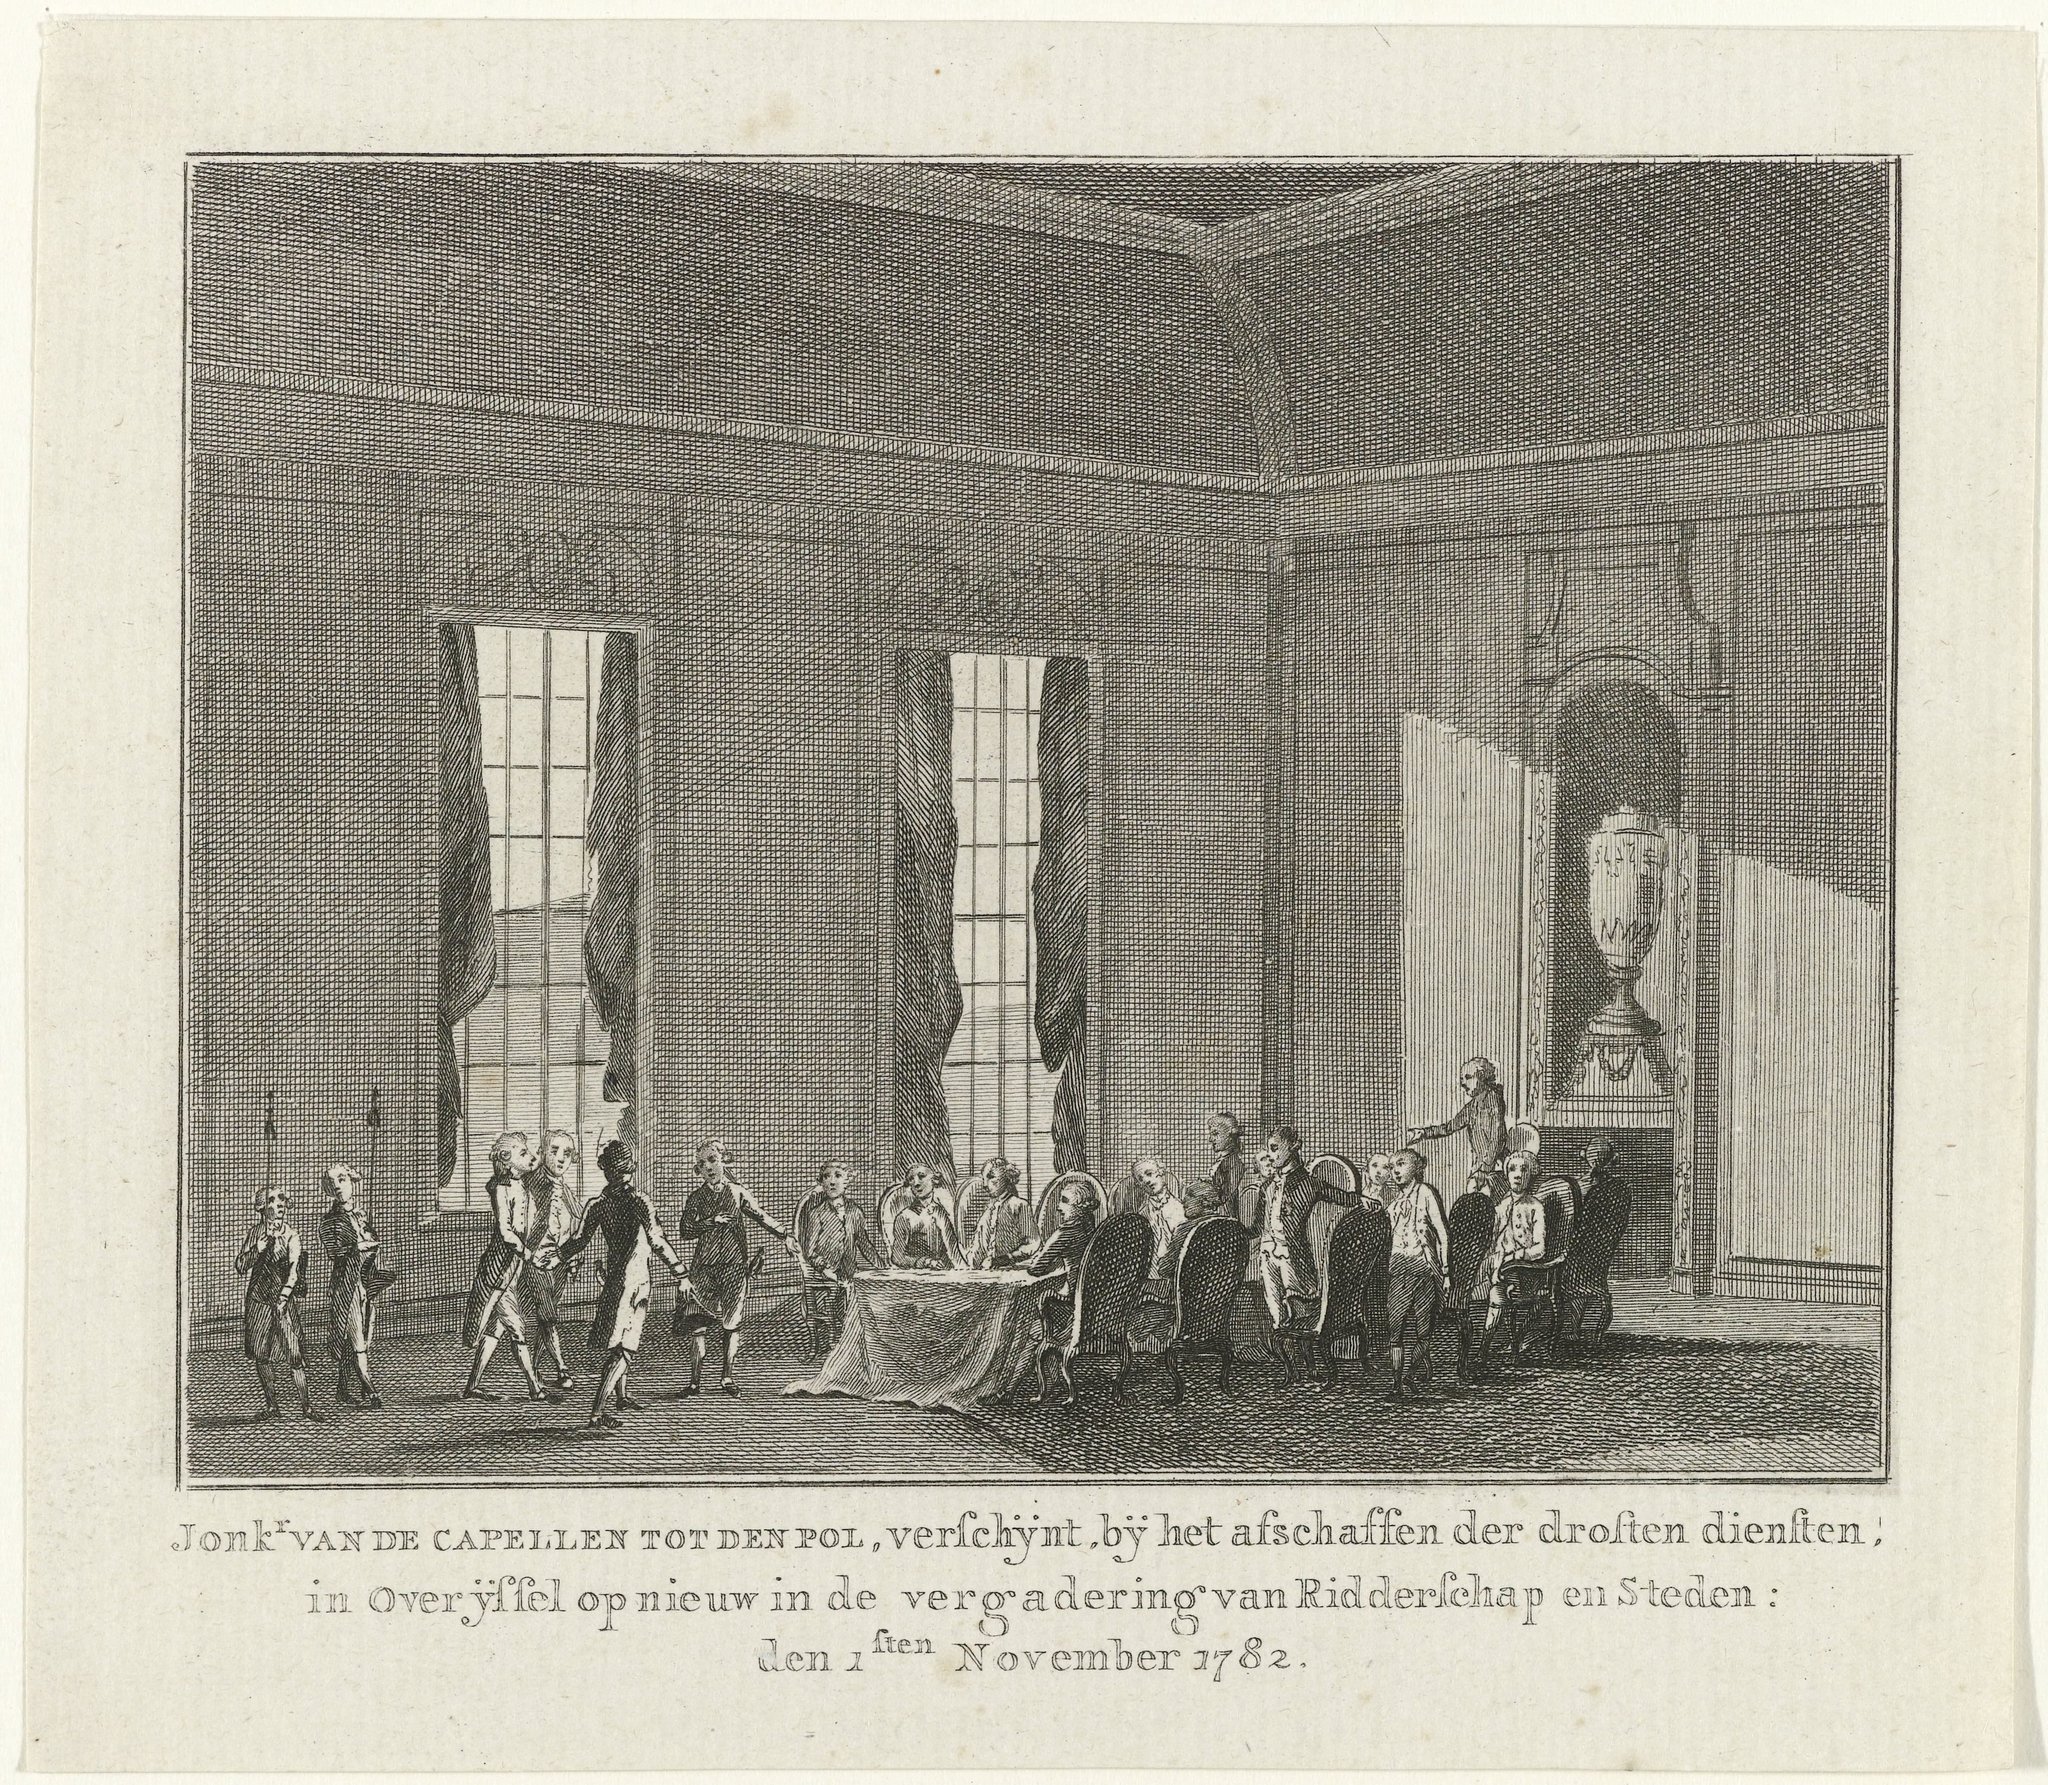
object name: print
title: Jonkr van de Capellen tot den Pol, verschijnt, bij het afschaffen der drosten diensten, in Overijssel opnieuw in de vergadering van Ridderschap en Steden: den 1sten November 1782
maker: mathias de sallieth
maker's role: print maker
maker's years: 1749-1791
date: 1787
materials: paper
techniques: engraving, etching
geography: northern netherlands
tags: politician, joan derk van der capellen tot den pol, patriots (1780-1795)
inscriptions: collector's mark: Lugt 2228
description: Joan Derk Baron van der Capellen tot den Poll verschijnt opnieuw in de vergadering van Ridderschap en Steden te Overijssel, 1 november 1782. Fragment van een grotere plaat met de titel 'Atlas der Geschiedenissen van onzen tyd. Plaat I'. Dit was een proefaflevering van een nieuwe reeks voorstellingen van historische gebeurtenissen uit de jaren 1780-1787, de reeks is na dit eerste nummer niet voortgezet.